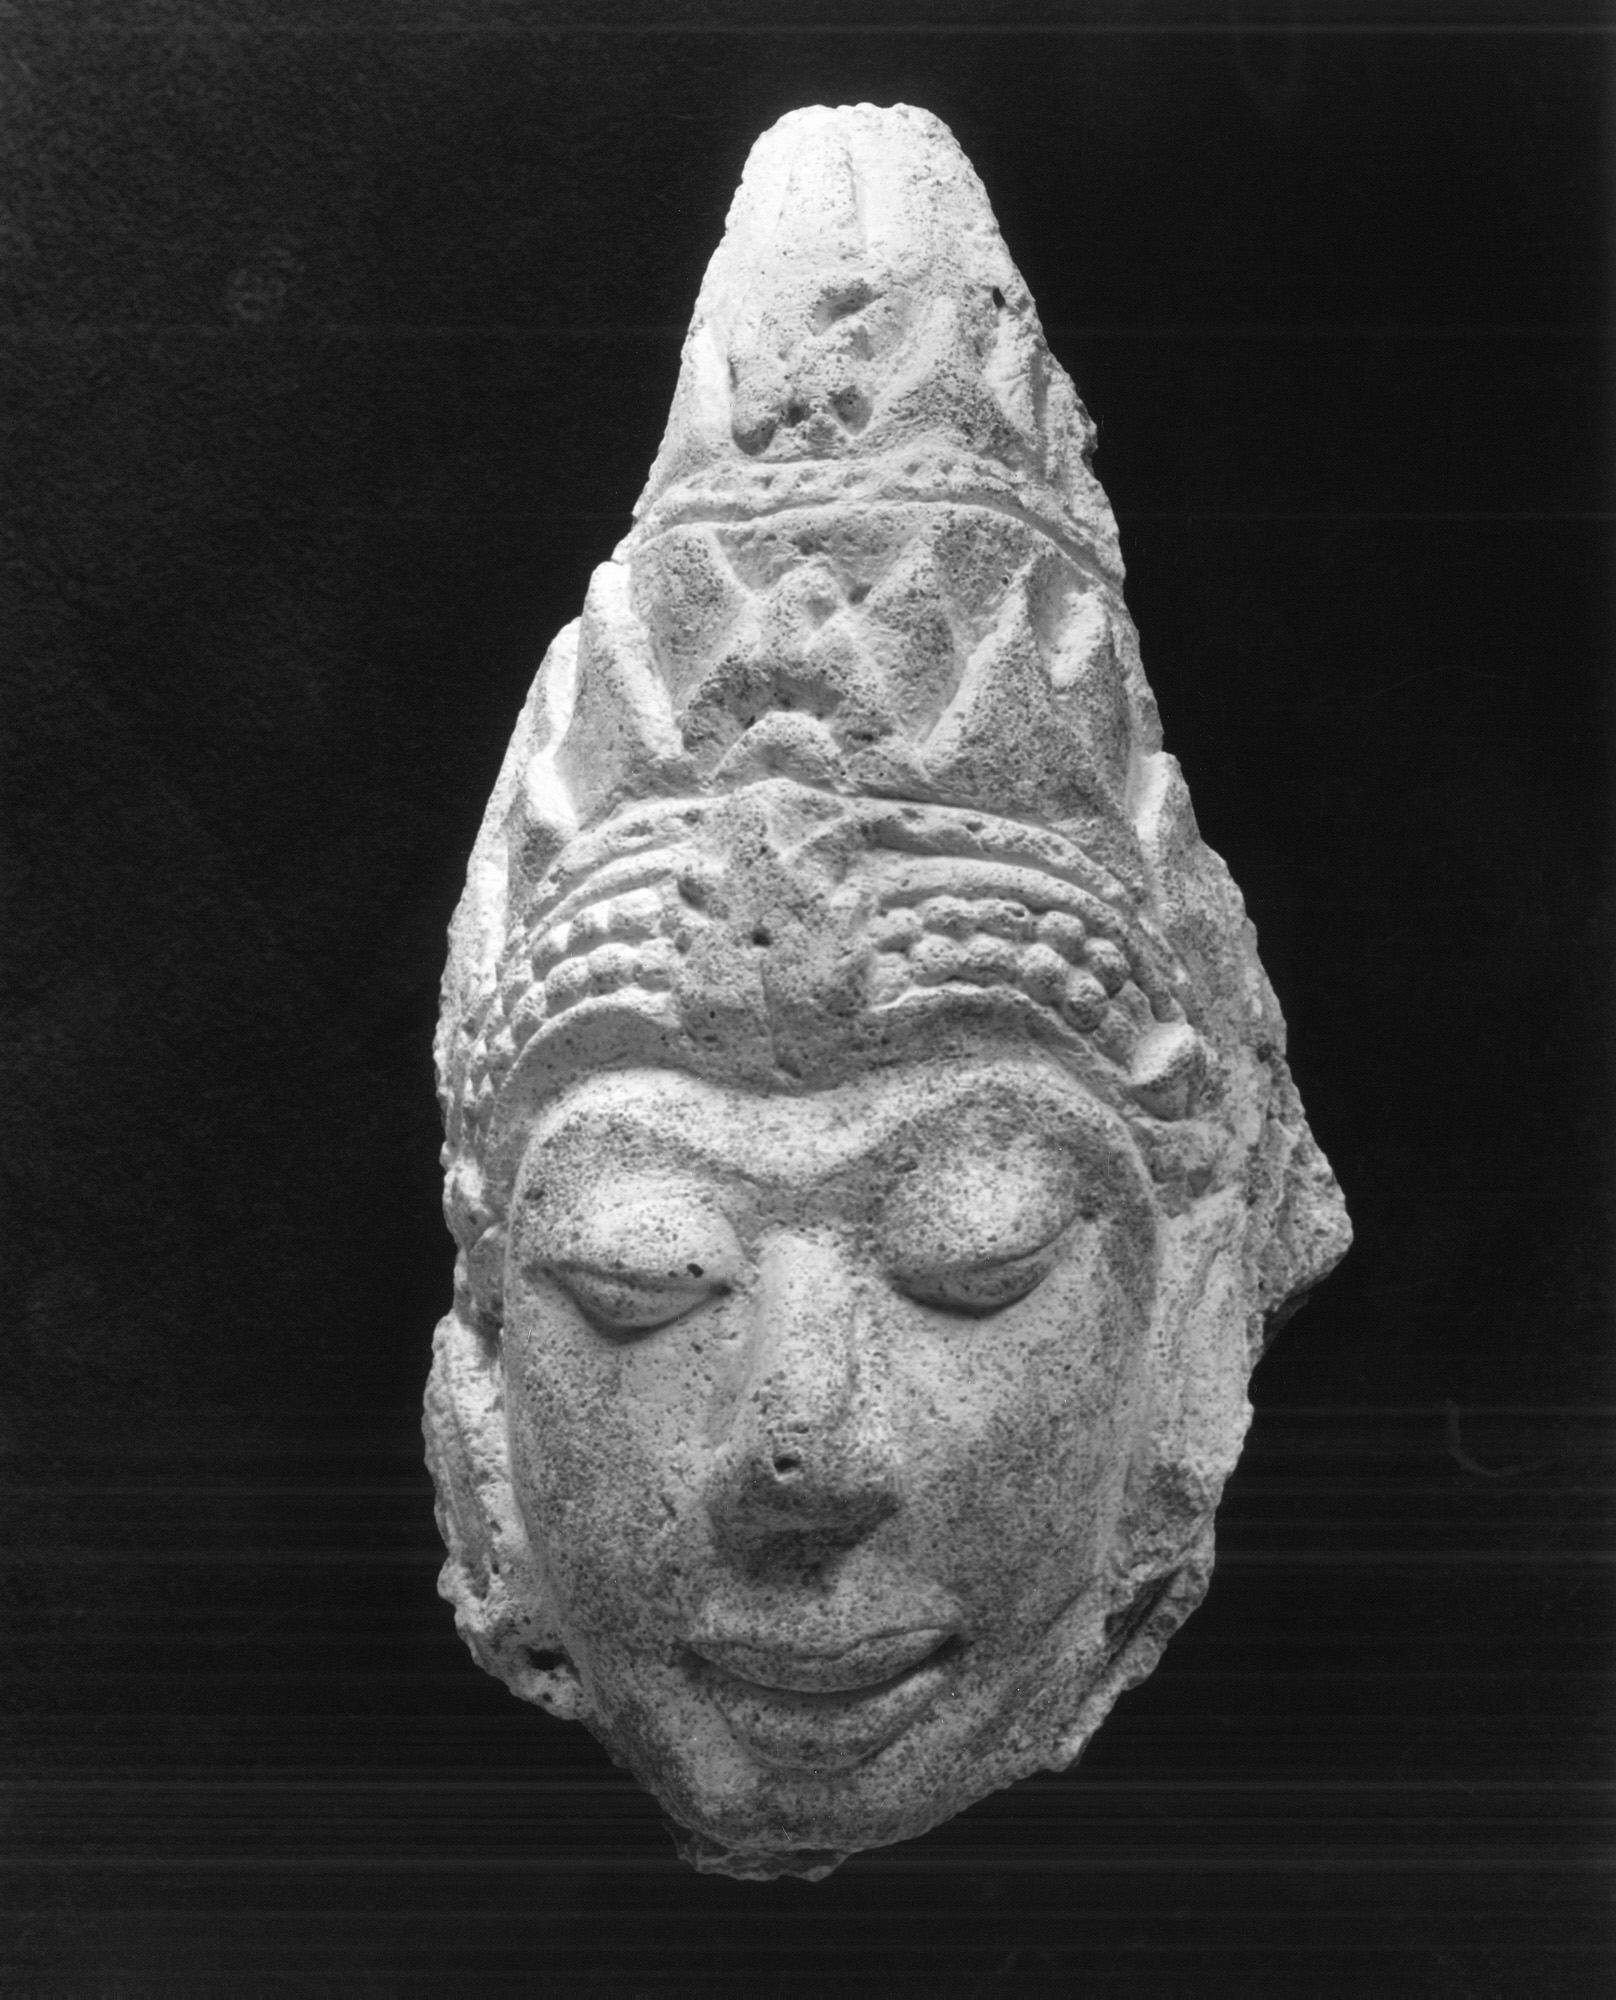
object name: head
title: Head of a Male Deity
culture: thai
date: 801-900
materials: plaster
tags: heads,men